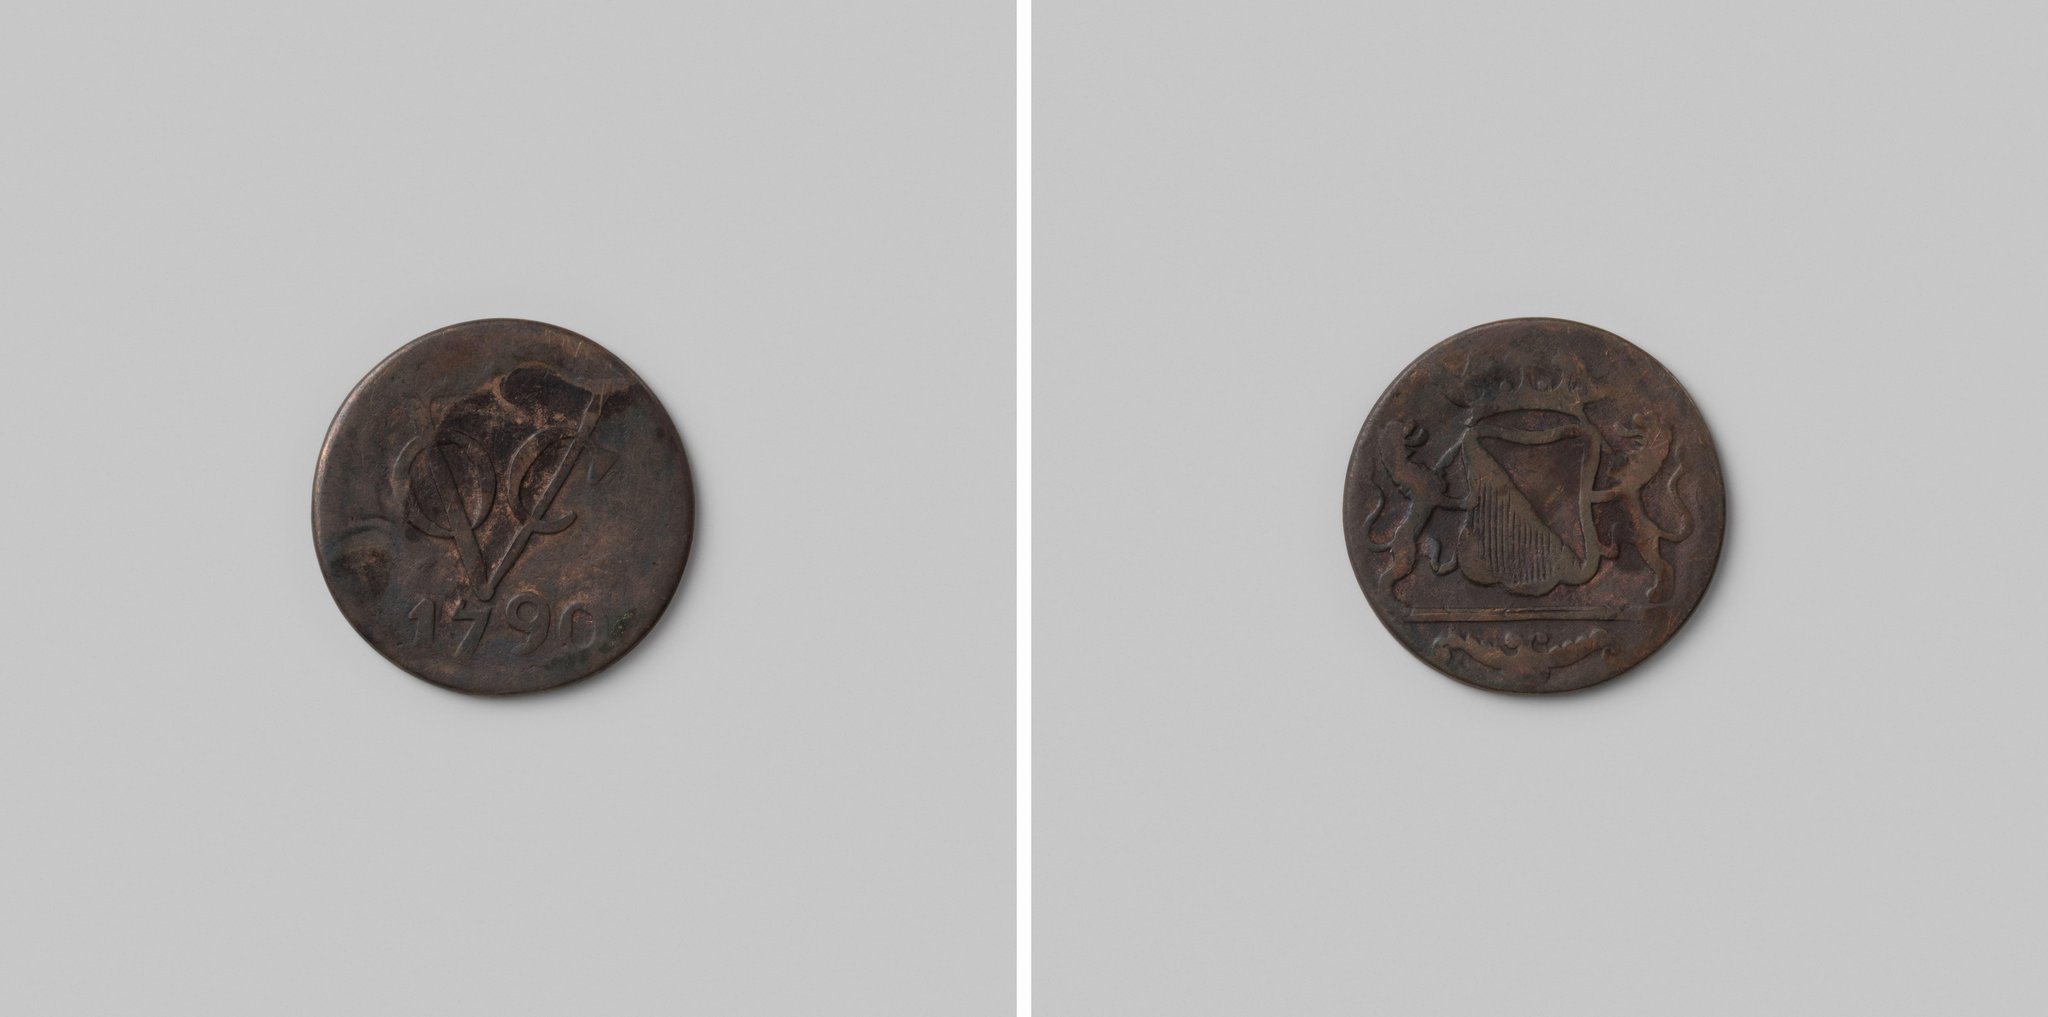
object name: coin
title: Koperen VOC-munt uit 1790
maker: Anonymous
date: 1790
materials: copper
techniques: striking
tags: verenigde oostindische compagnie, oost-indië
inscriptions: date: ‘1790’, inscription: ‘Jacques Schulman N.V. / Numismaten / Keizersgracht 448 / Amsterdam-C.’, inscription: ‘VOC (als teken van de VOC, letters door elkaar, geschreven)’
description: Koperen muntje. Voorzijde: het teken van de VOC (VOC door elkaar heen geschreven), hieronder het jaartal 1790. Keerzijde: door twee leeuwen vastgehouden gekroond wapen. Het muntje zit in een vierkant envelopje met opschrift.